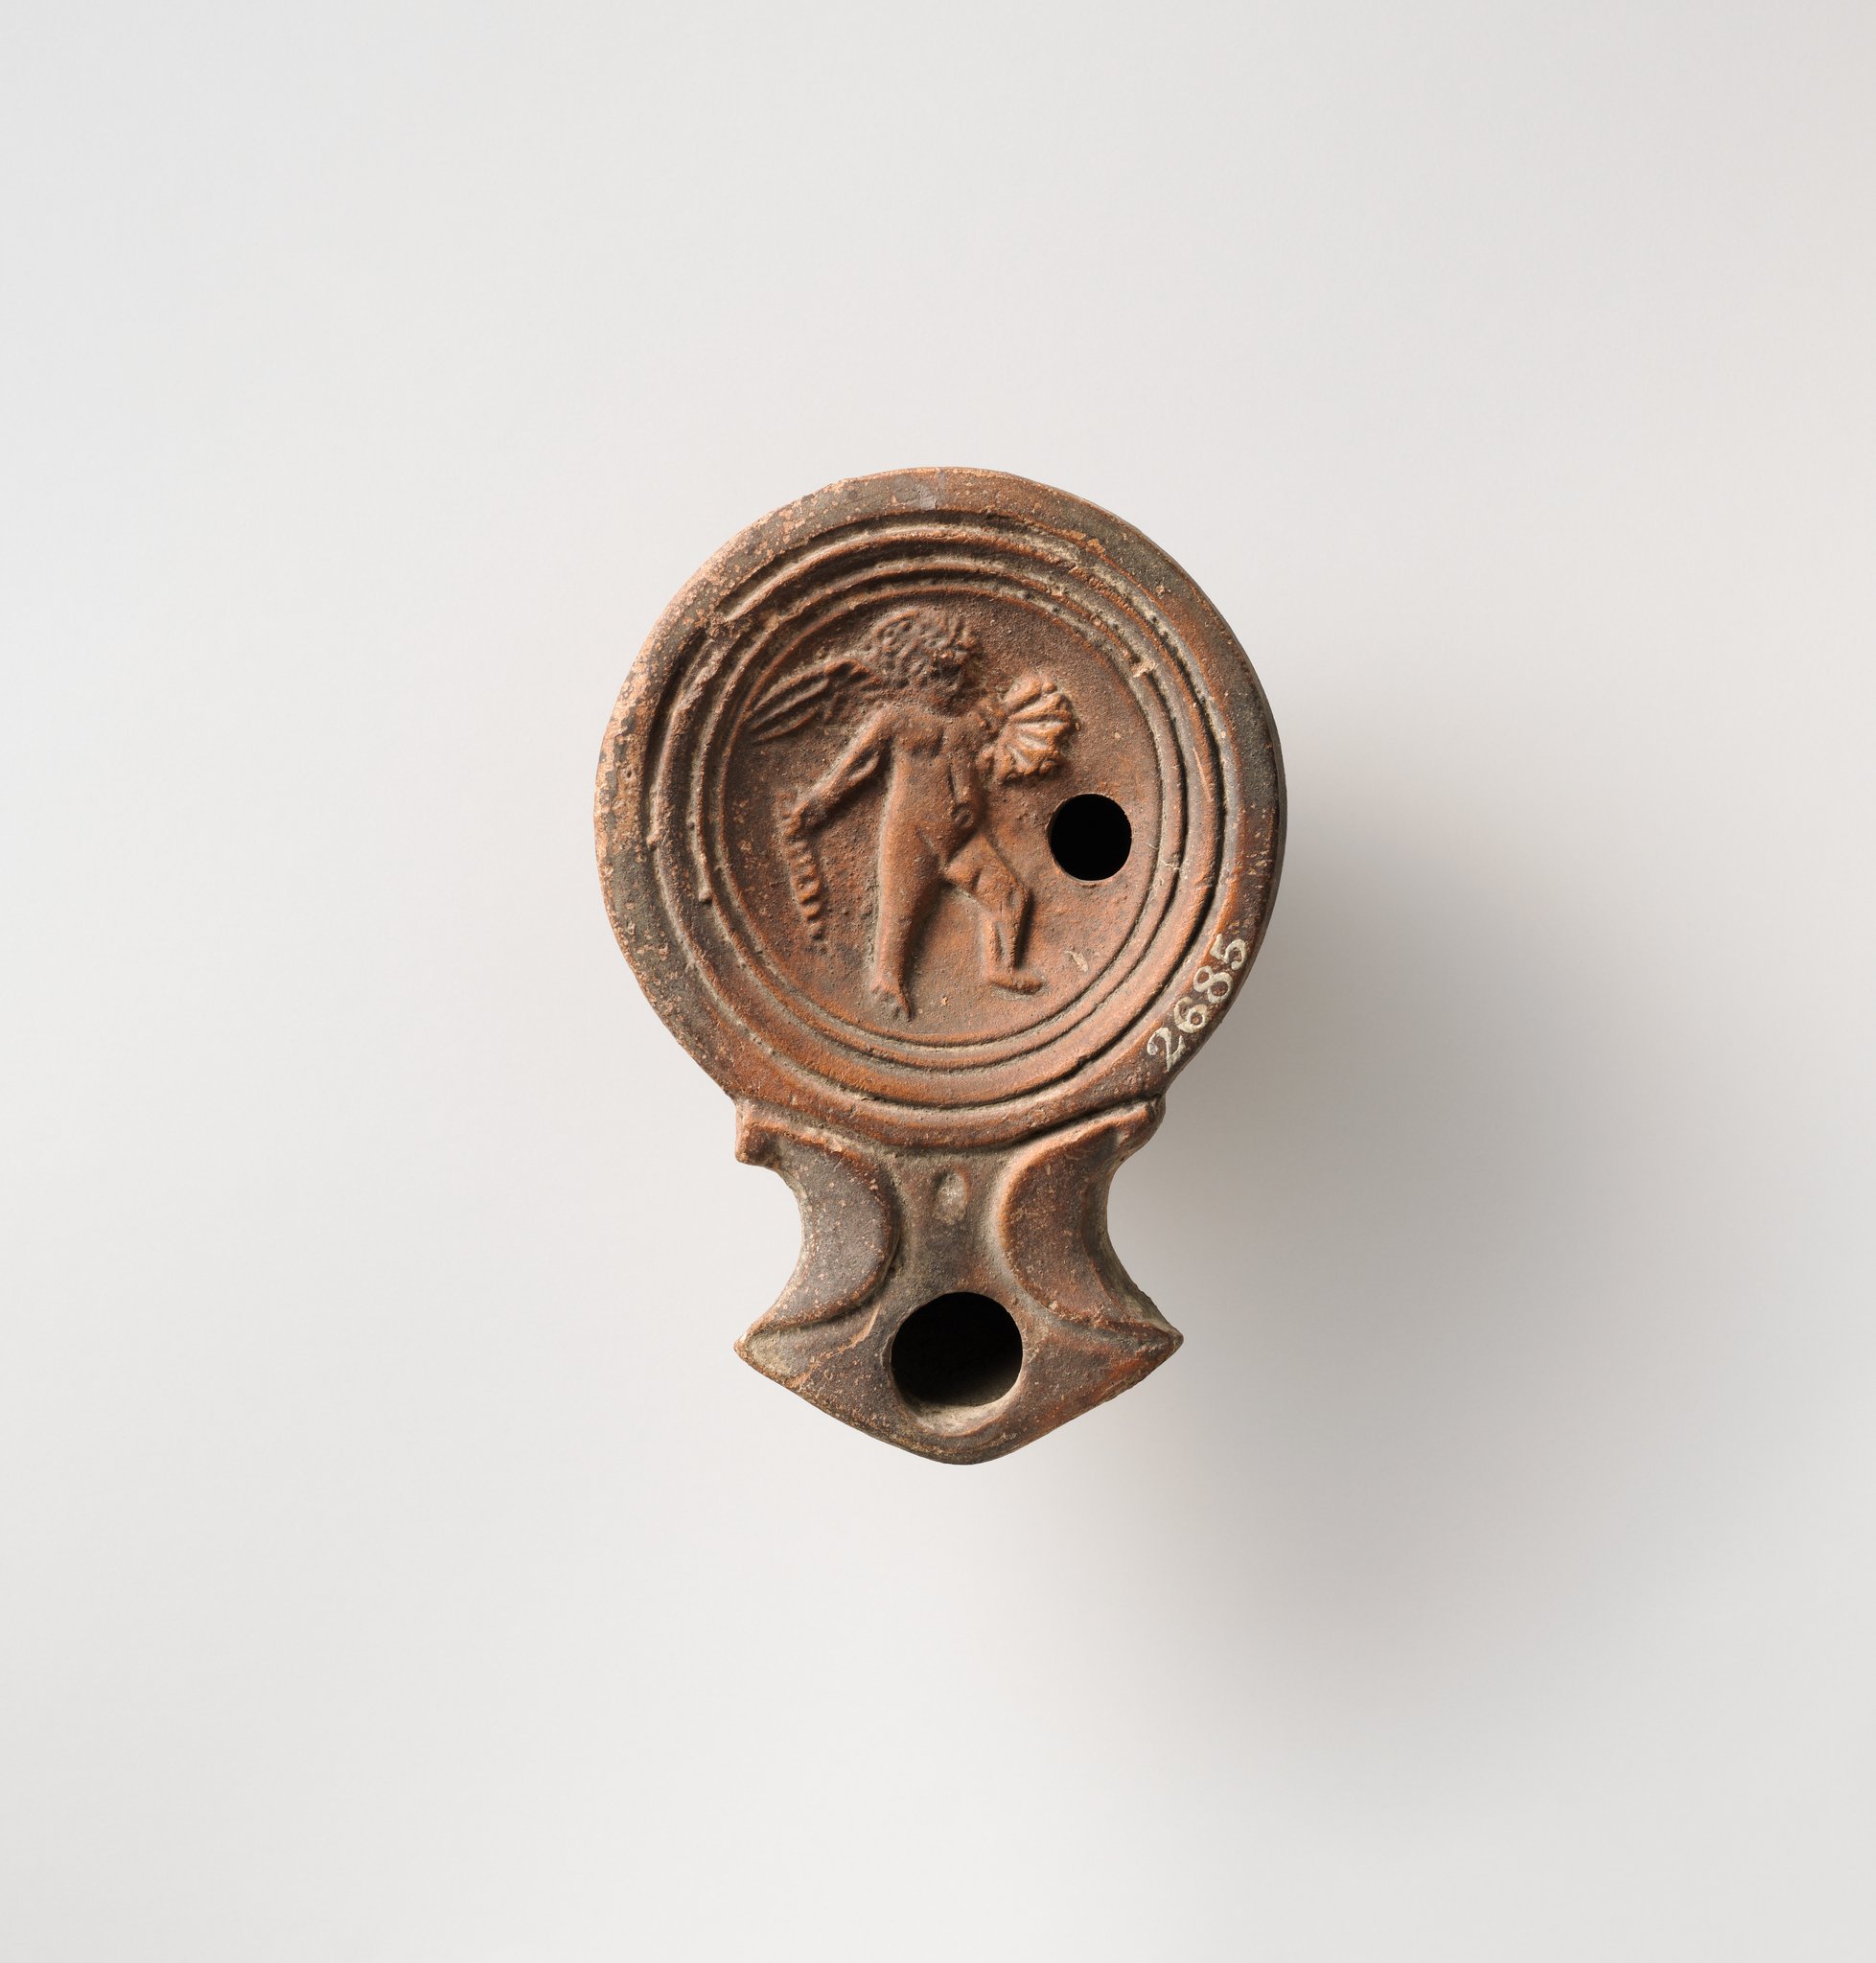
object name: lamp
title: Terracotta oil lamp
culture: roman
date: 70-100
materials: terracotta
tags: eros